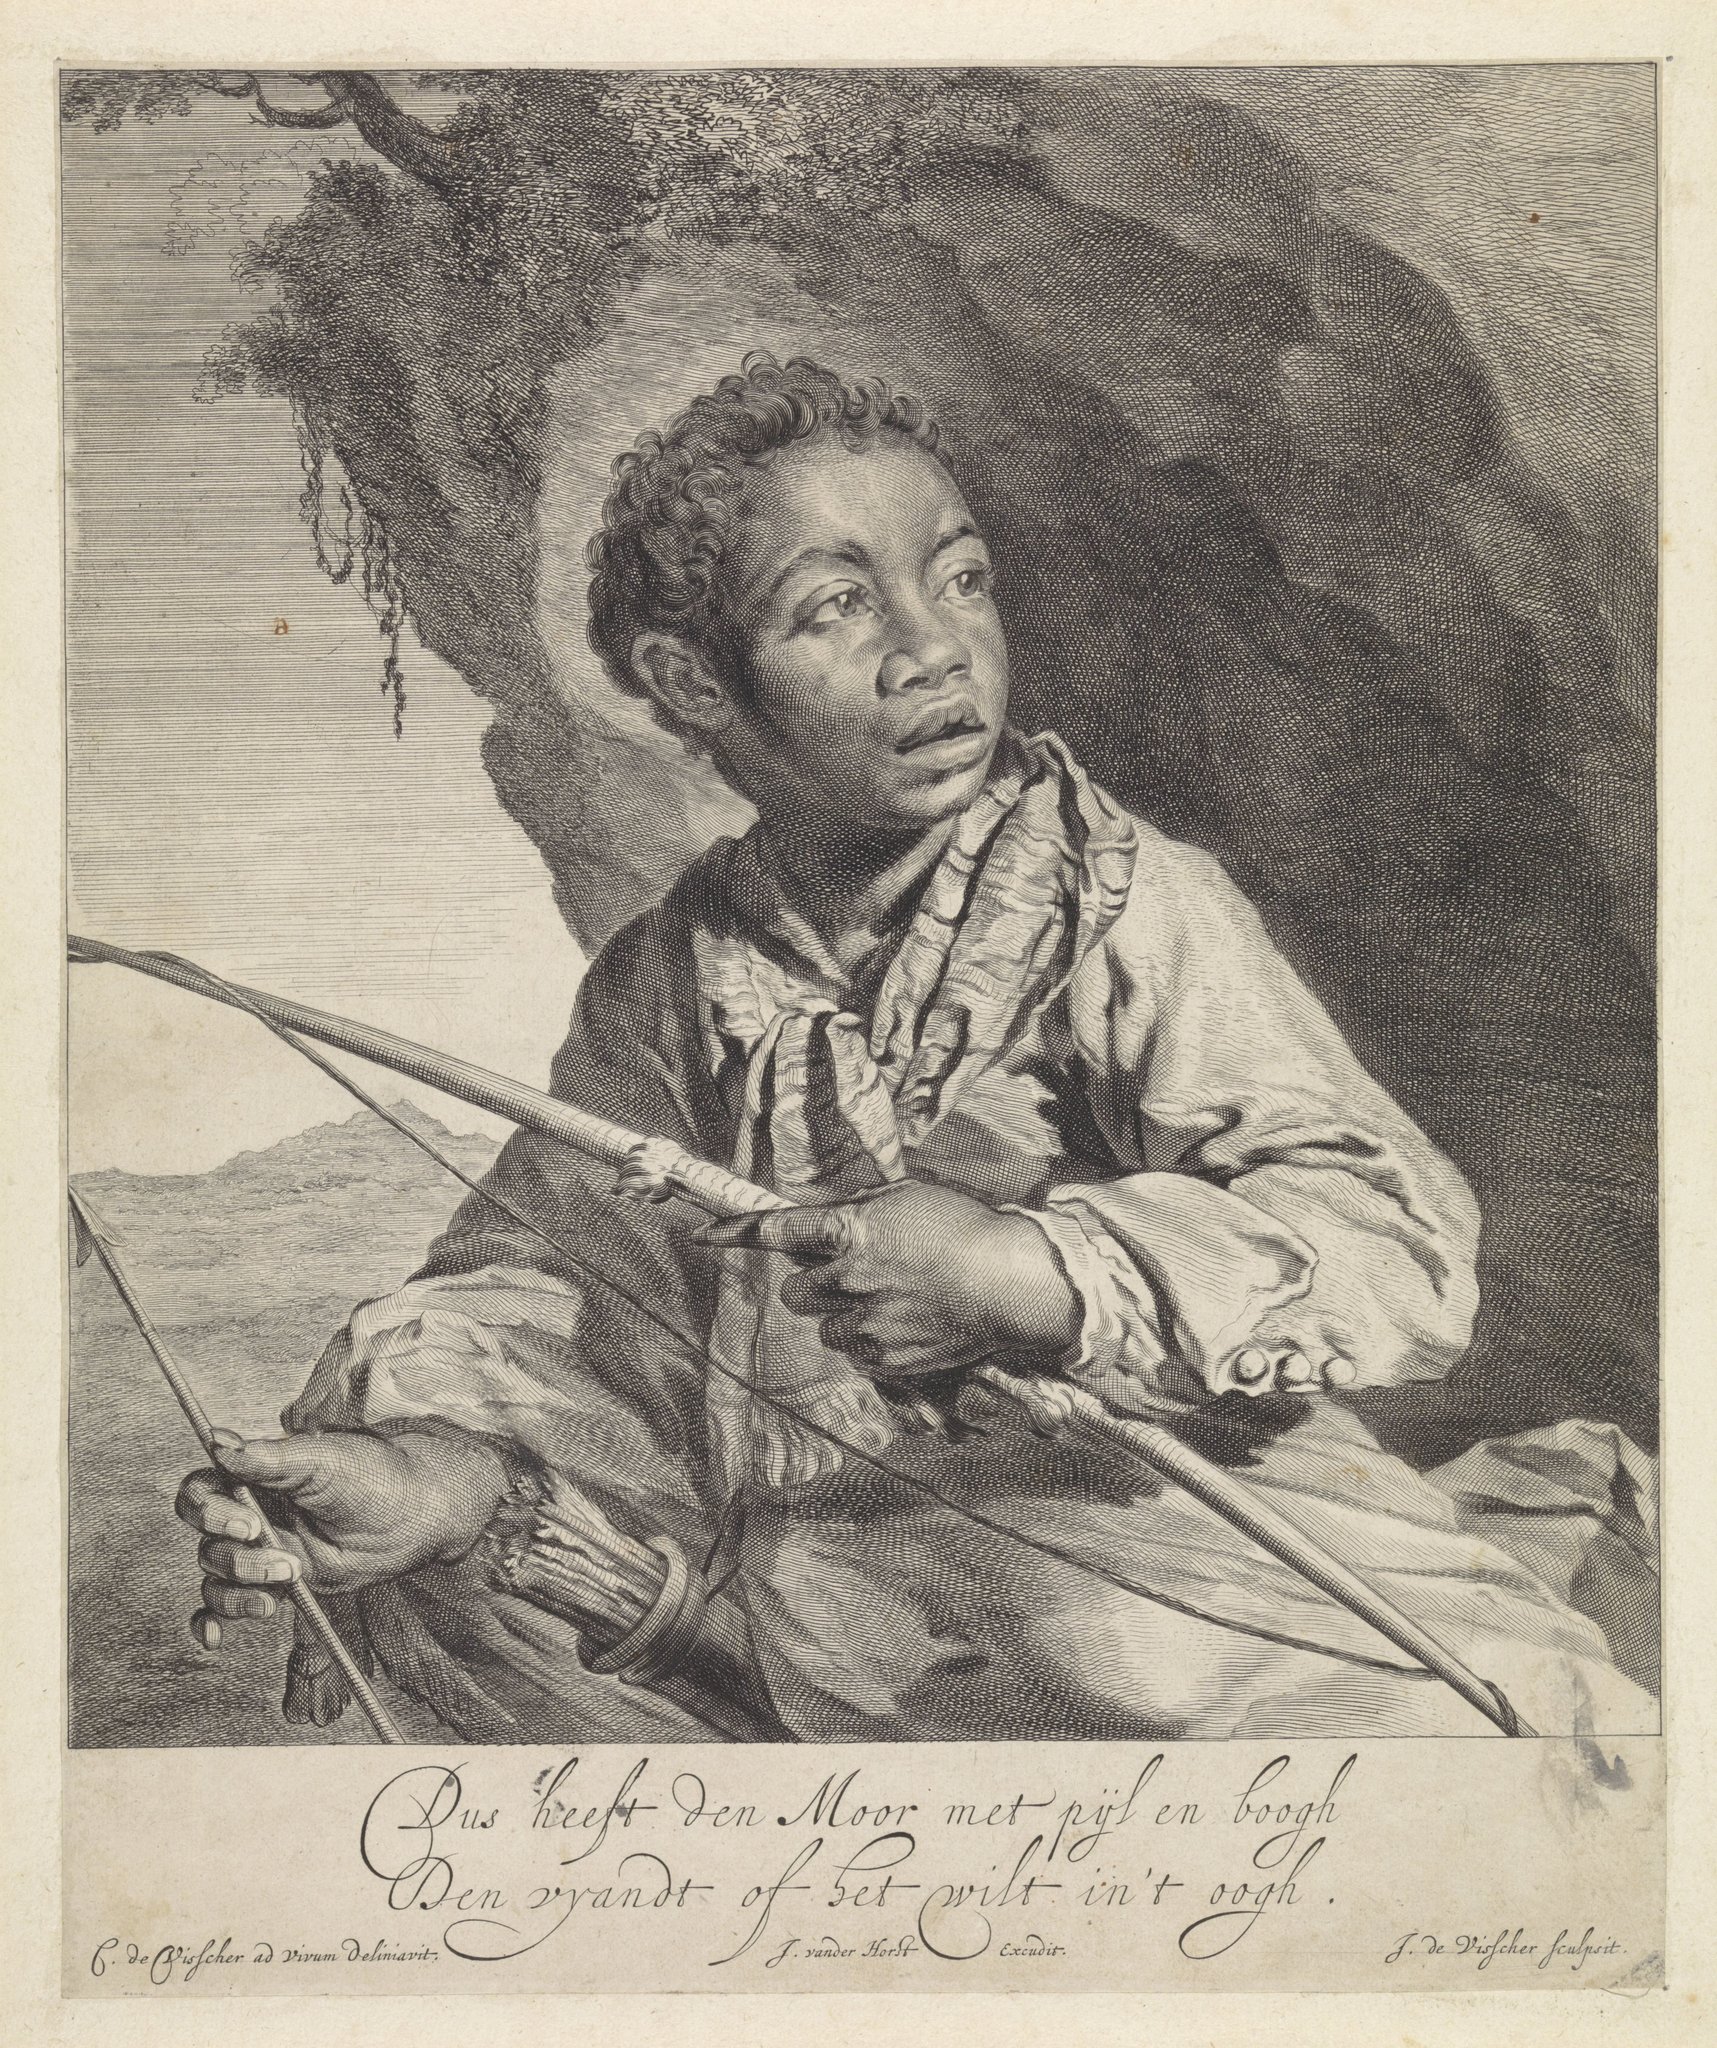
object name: print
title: Boogschutter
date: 1643-1692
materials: paper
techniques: engraving, etching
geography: northern netherlands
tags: archer's weapons: bow and arrow, landscapes, africans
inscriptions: collector's mark: Lugt 240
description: Een jonge Afrikaan met een pijl en boog voor een rots. Op de achtergrond een landschap.